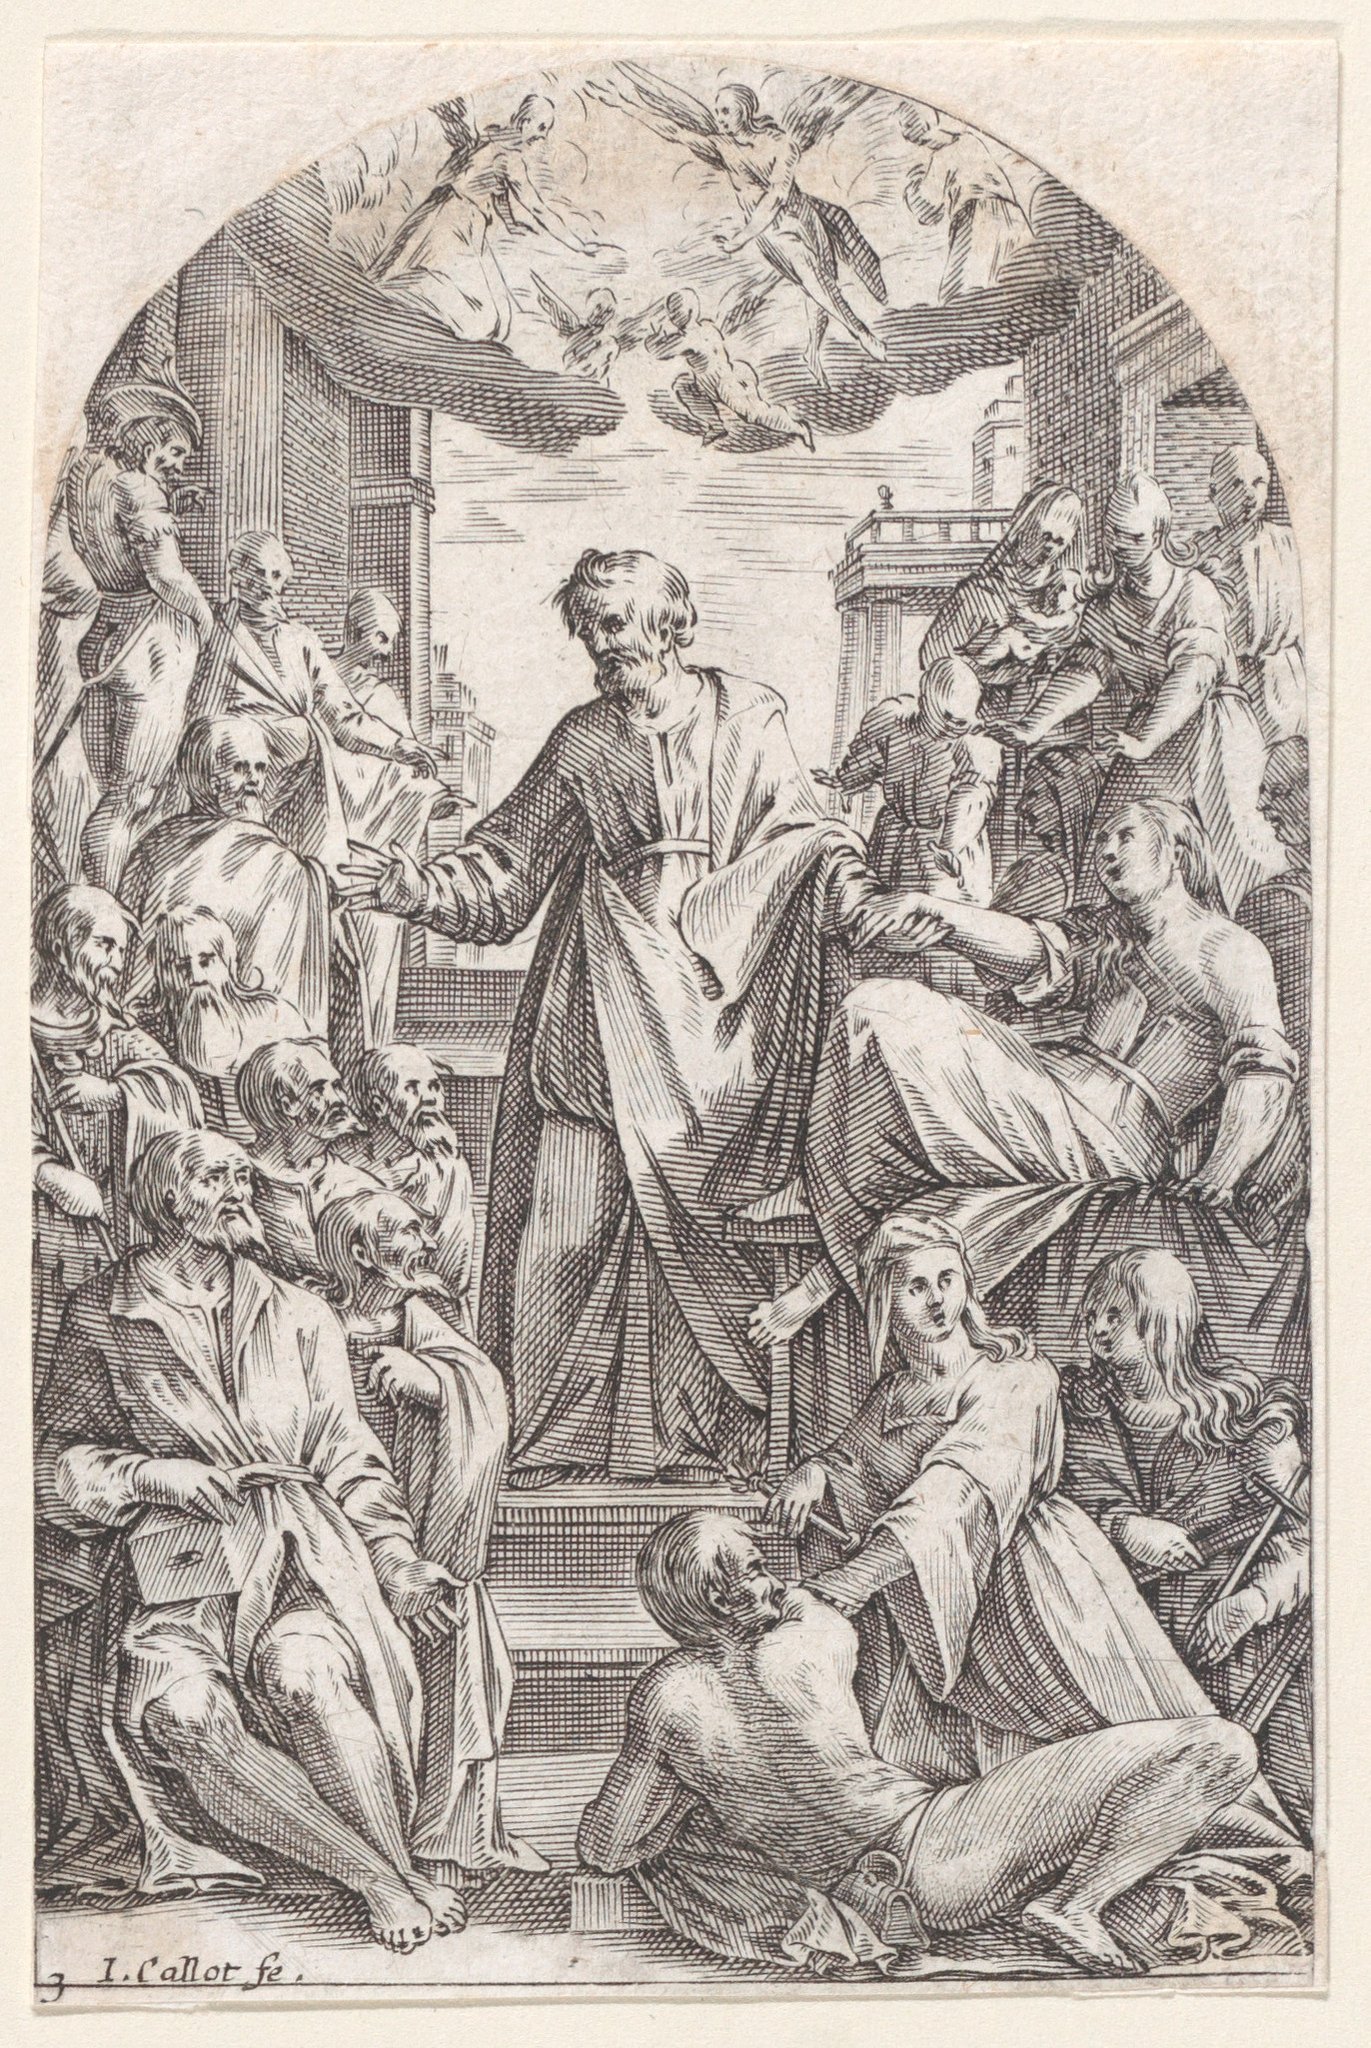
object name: print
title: St. Peter Resucitating Tabitha, plate 3 from "Les Tableaux de Rome, Les Eglises Jubilaires" (The Paintings of Rome, The Churches Jubilee)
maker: jacques callot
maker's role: artist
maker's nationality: french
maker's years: 1592-1635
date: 1607-1611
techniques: engraving